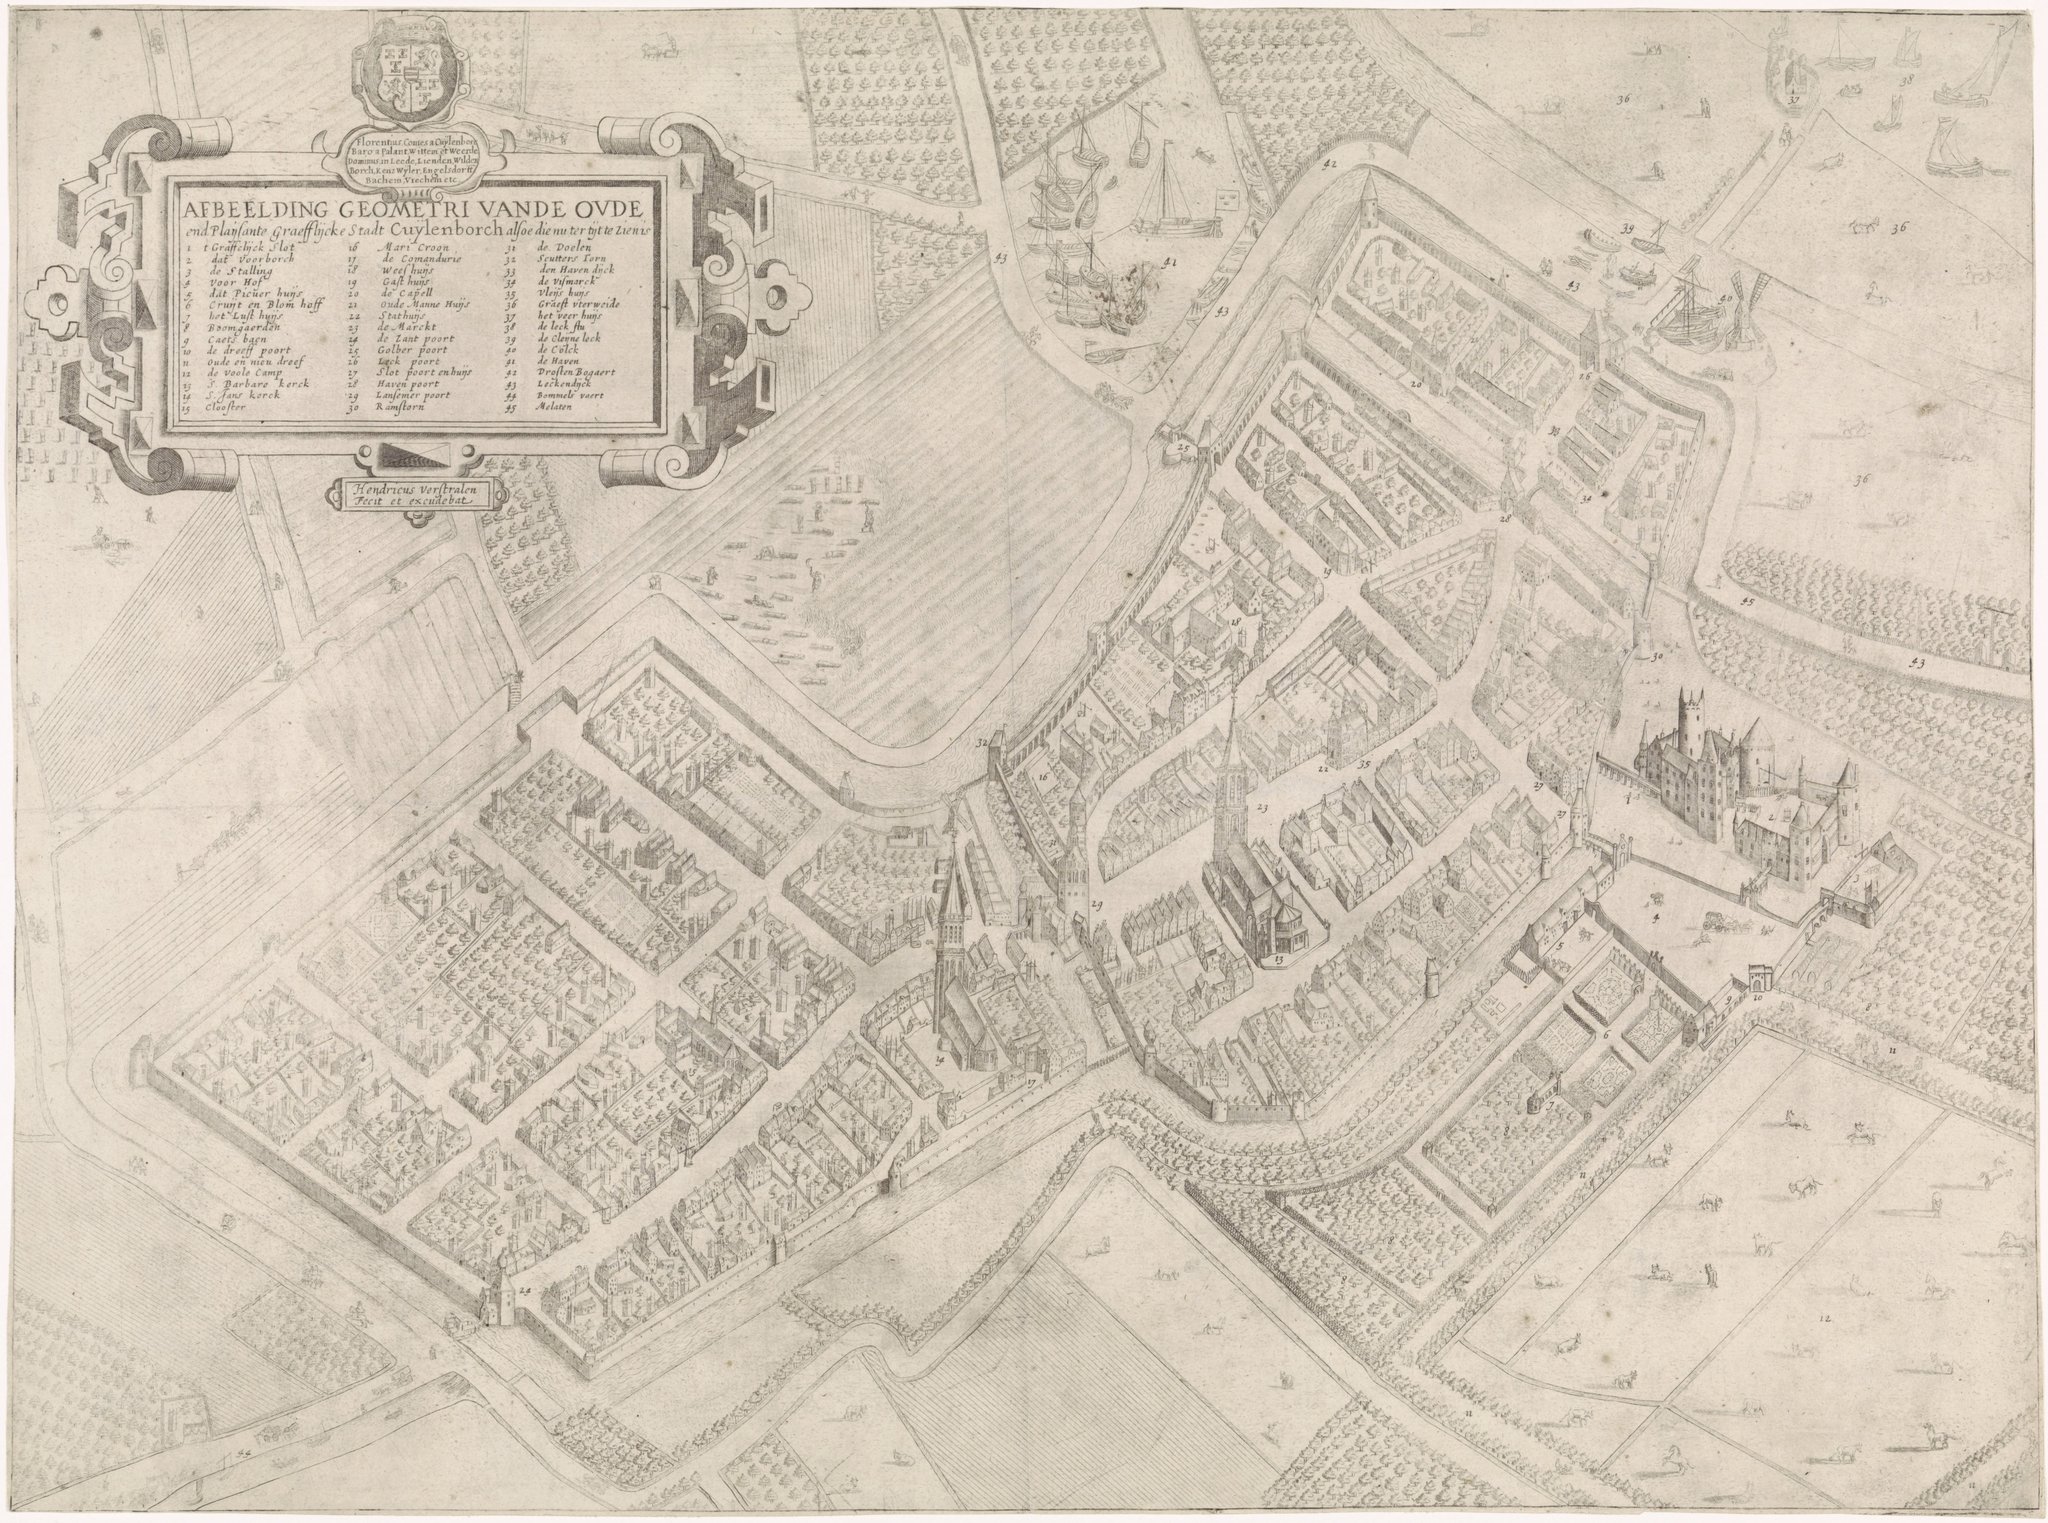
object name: print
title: Plattegrond van Culemborg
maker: hendrik jansz. verstraelen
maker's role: print maker, publisher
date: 1598-1622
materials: paper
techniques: engraving, etching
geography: utrecht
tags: culemborg